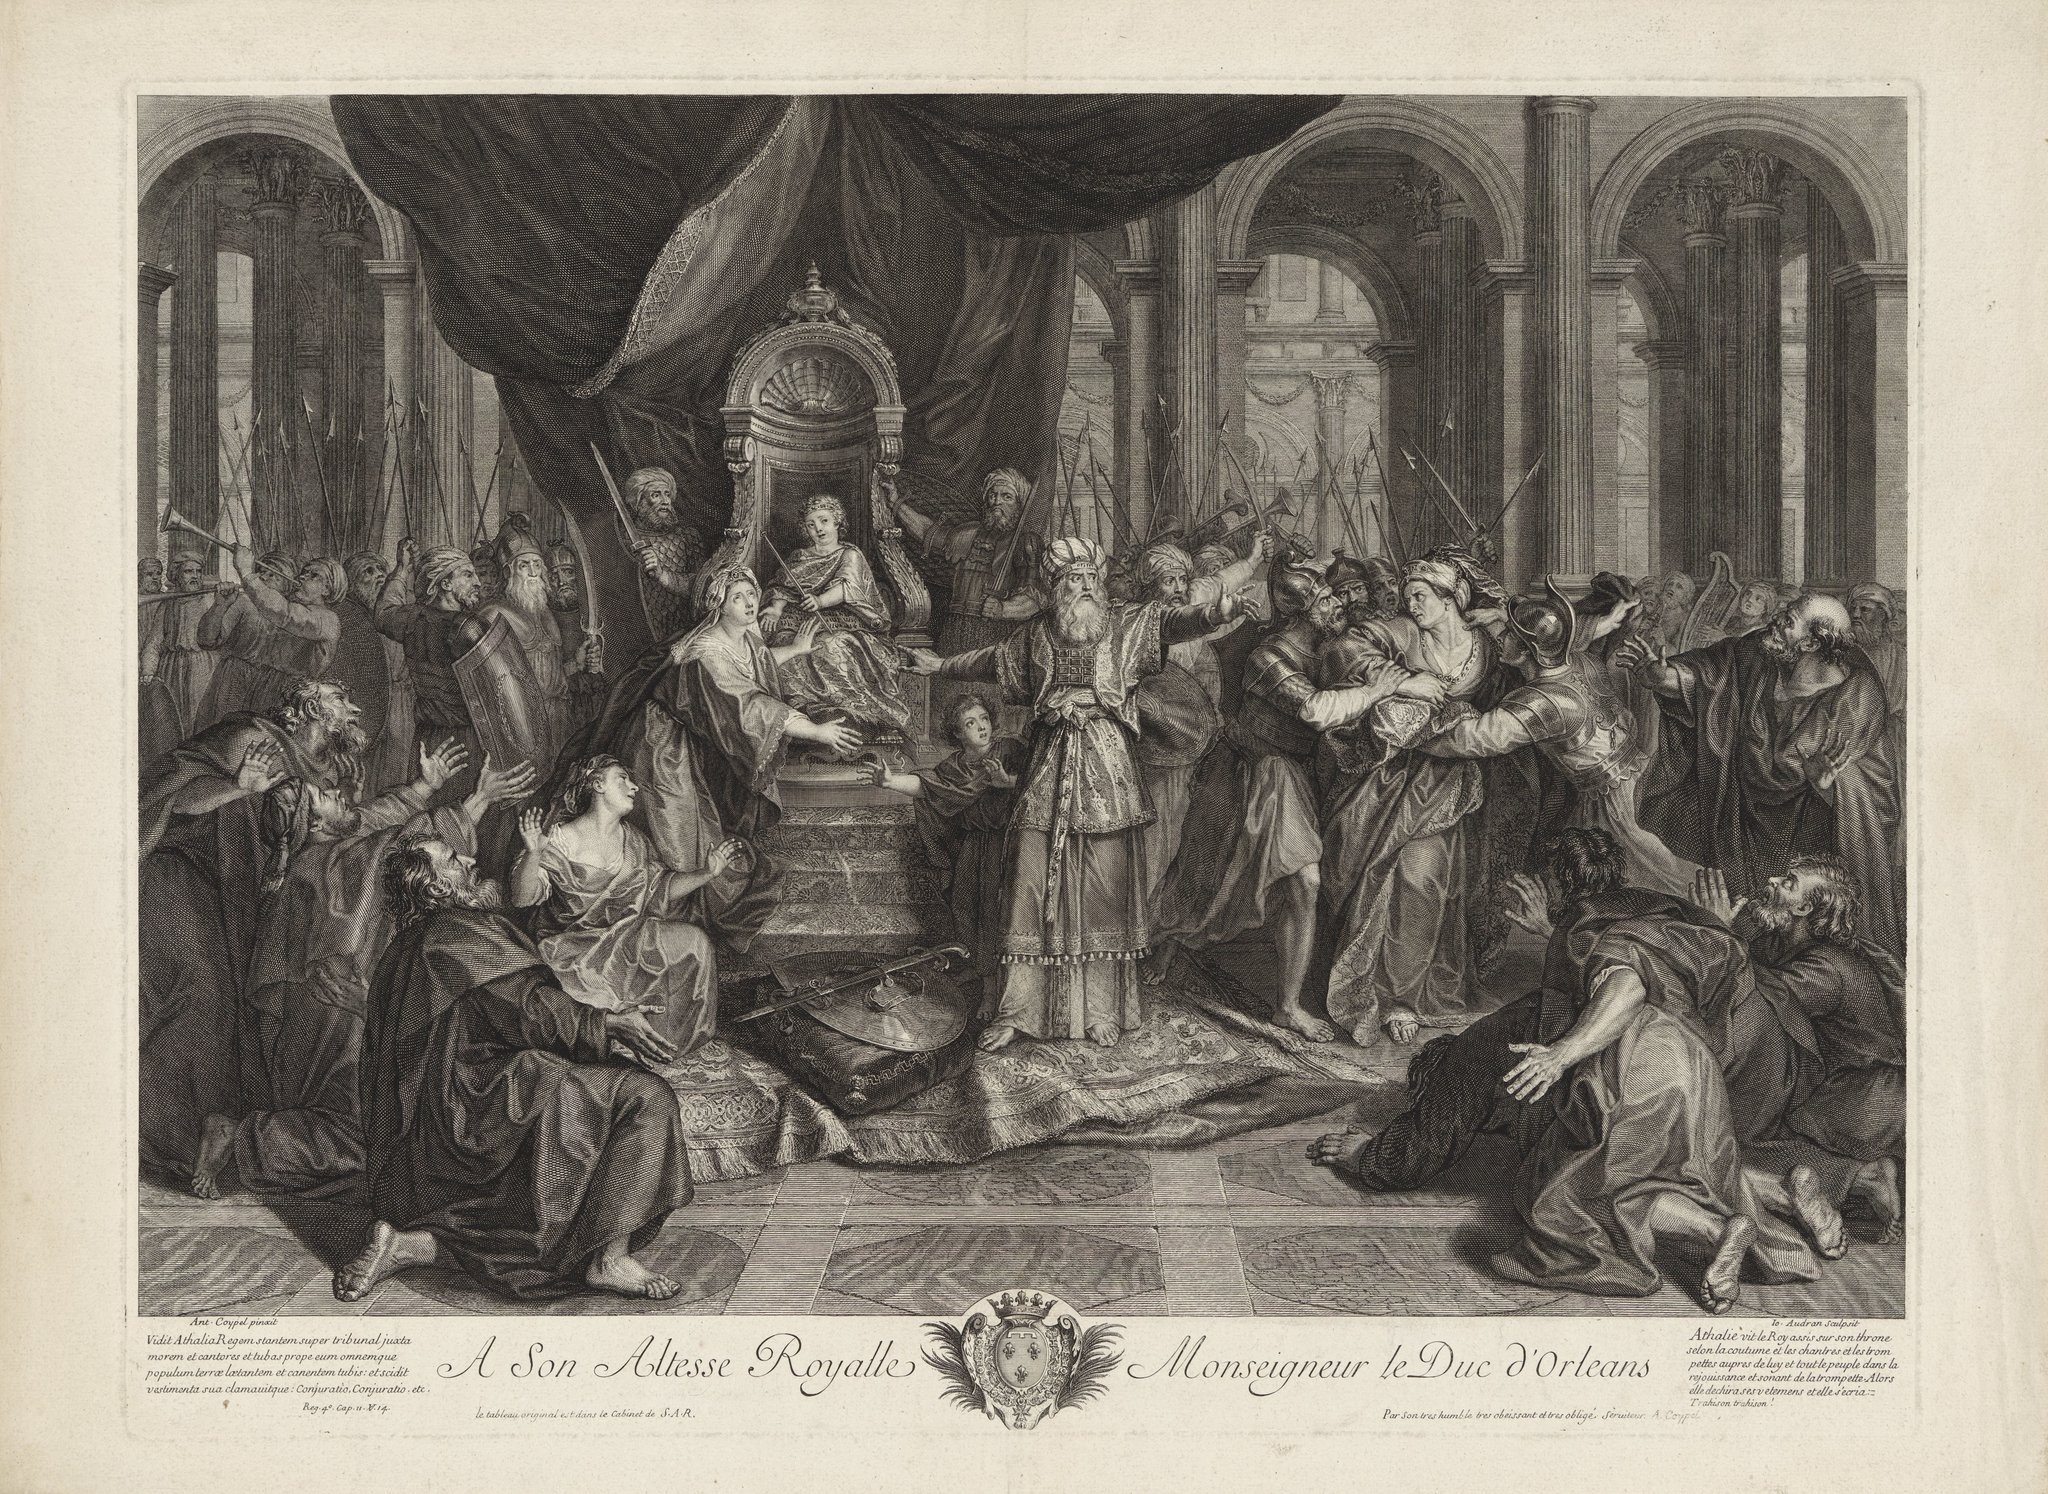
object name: print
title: Atalja en Joas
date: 1677-1756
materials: paper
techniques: engraving, etching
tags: story of athalia, queen of judah (2 kings 11:1-3, 11:13-16; 2 chronicles 22:10-12, 23:12-15), athalia hearing the noise of the people acclaiming king joash, comes to the temple and sees the new king standing by a pillar; she tears her clothes in dismay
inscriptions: collector's mark: Lugt 2228